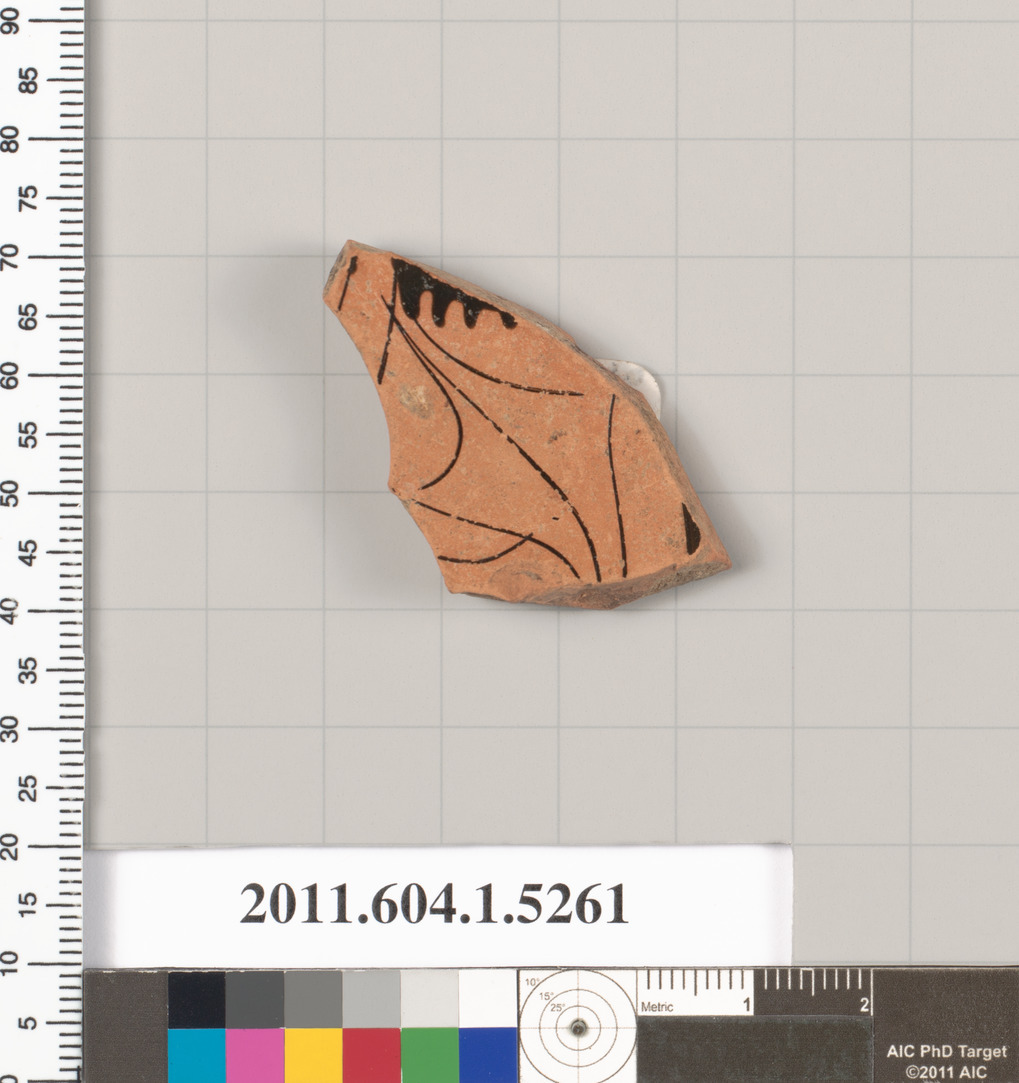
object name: kylix fragment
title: Terracotta fragment of a kylix (drinking cup)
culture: greek, attic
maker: pithos painter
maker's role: artist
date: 534-501 BCE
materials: terracotta